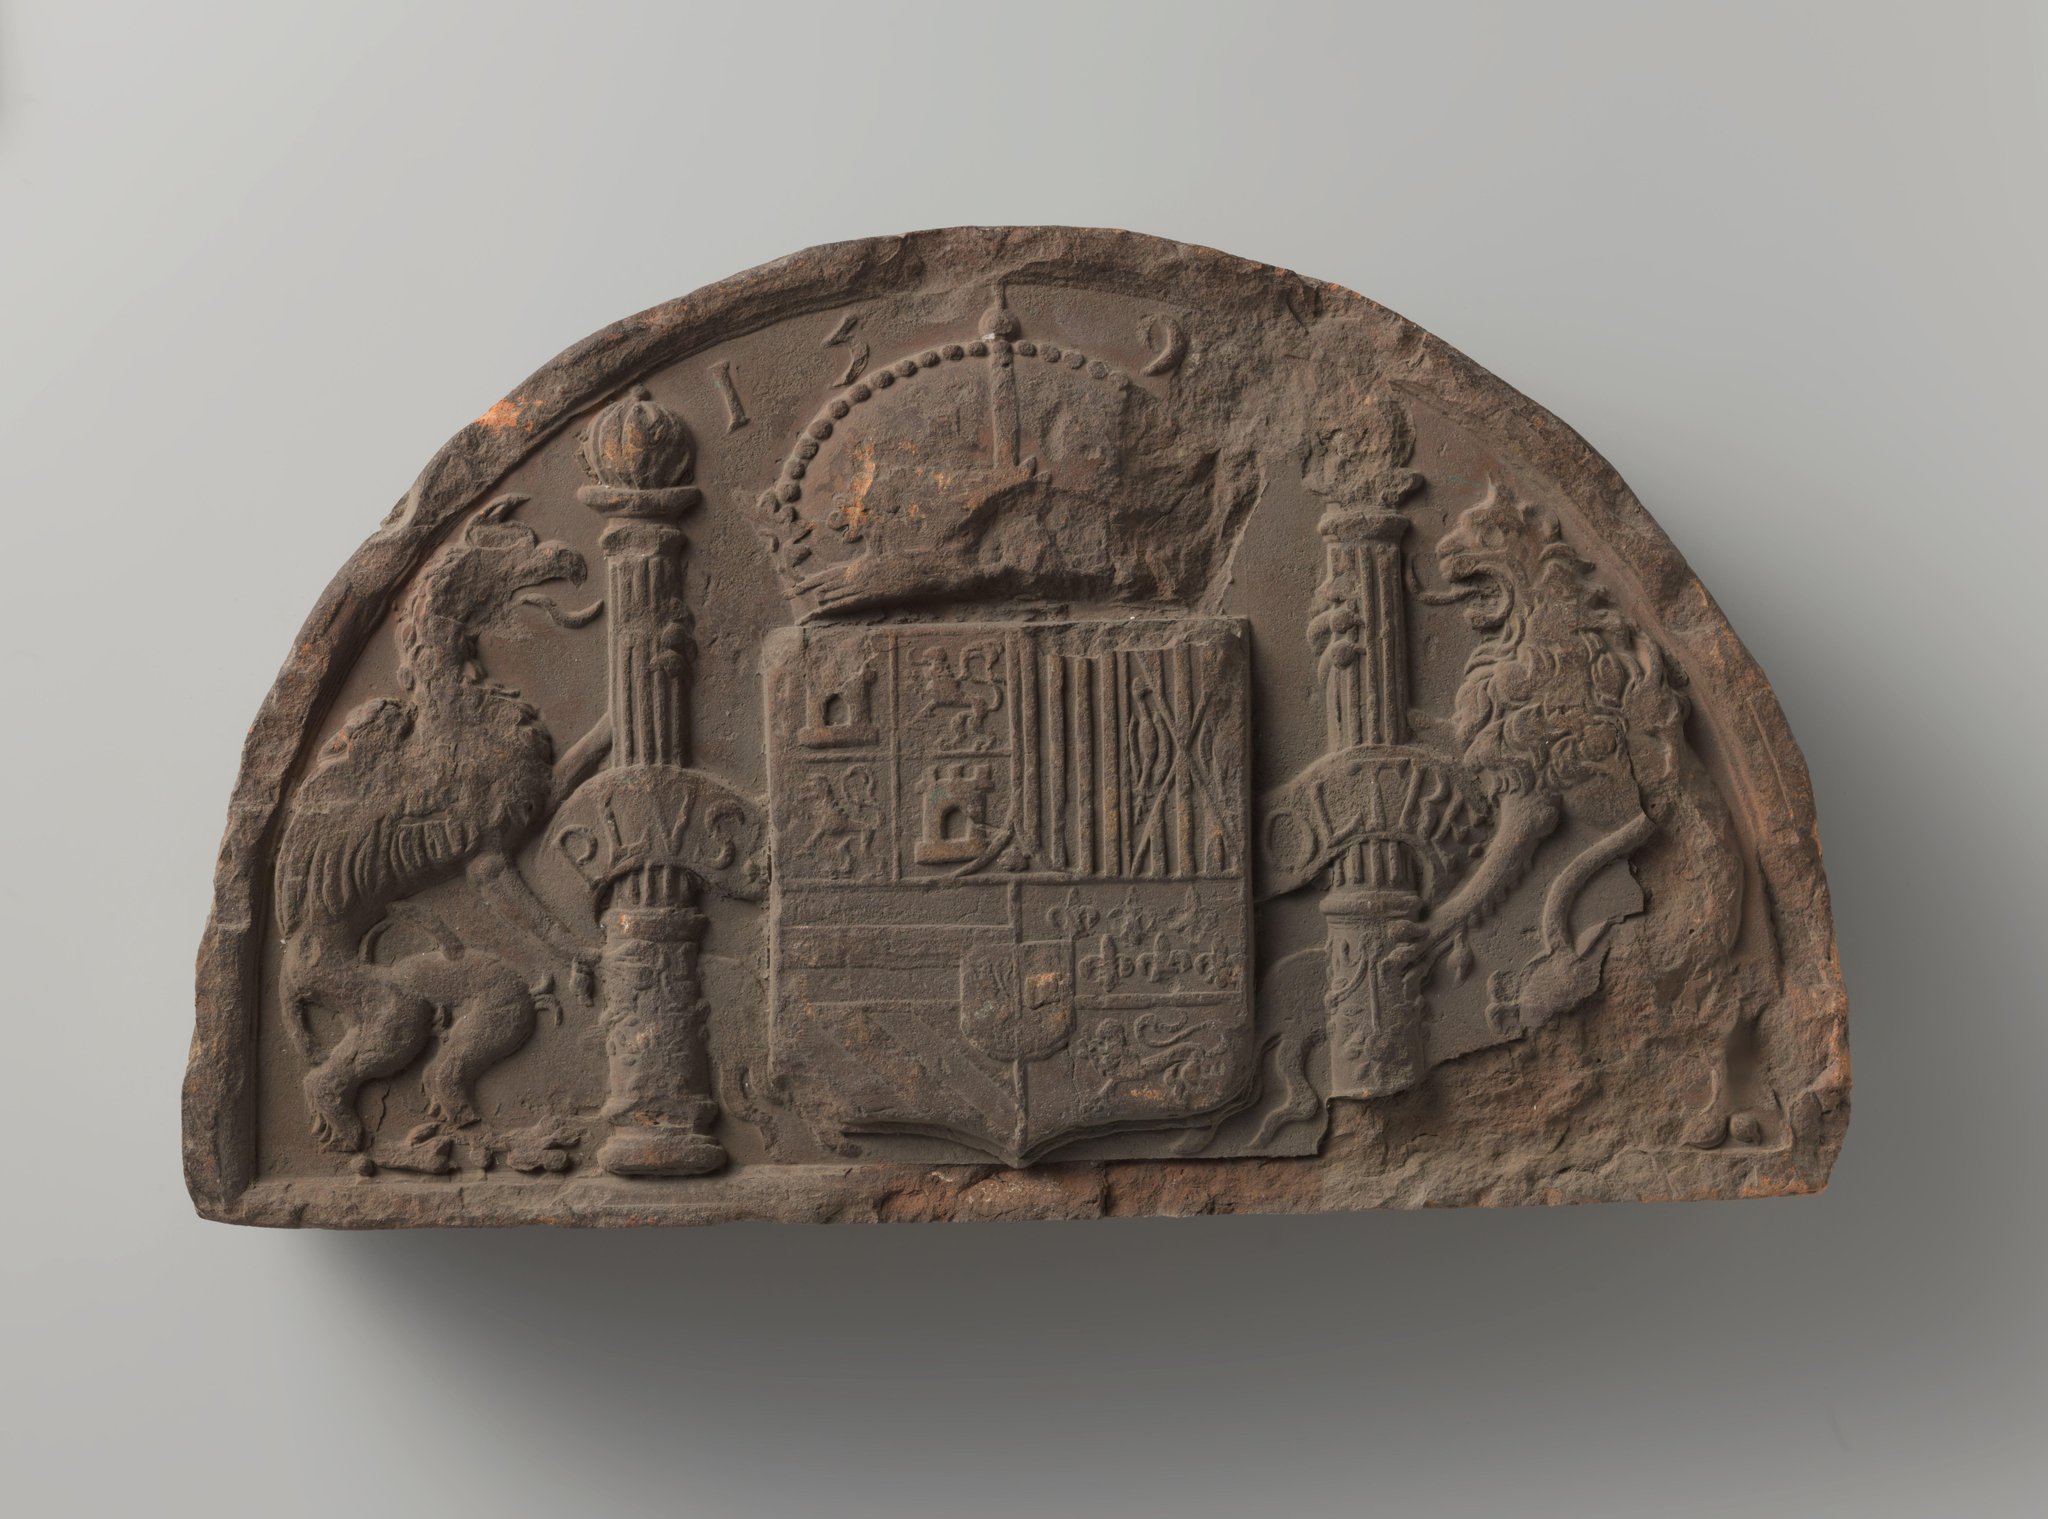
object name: hearthstone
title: Haardsteen met het de wapenspreuk Plus Oltre van Karel V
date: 1590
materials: earthenware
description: Haardsteen met de wapenspreuk Plus Oltre van Karel V en vergezeld van het jaartal 1590 (?).